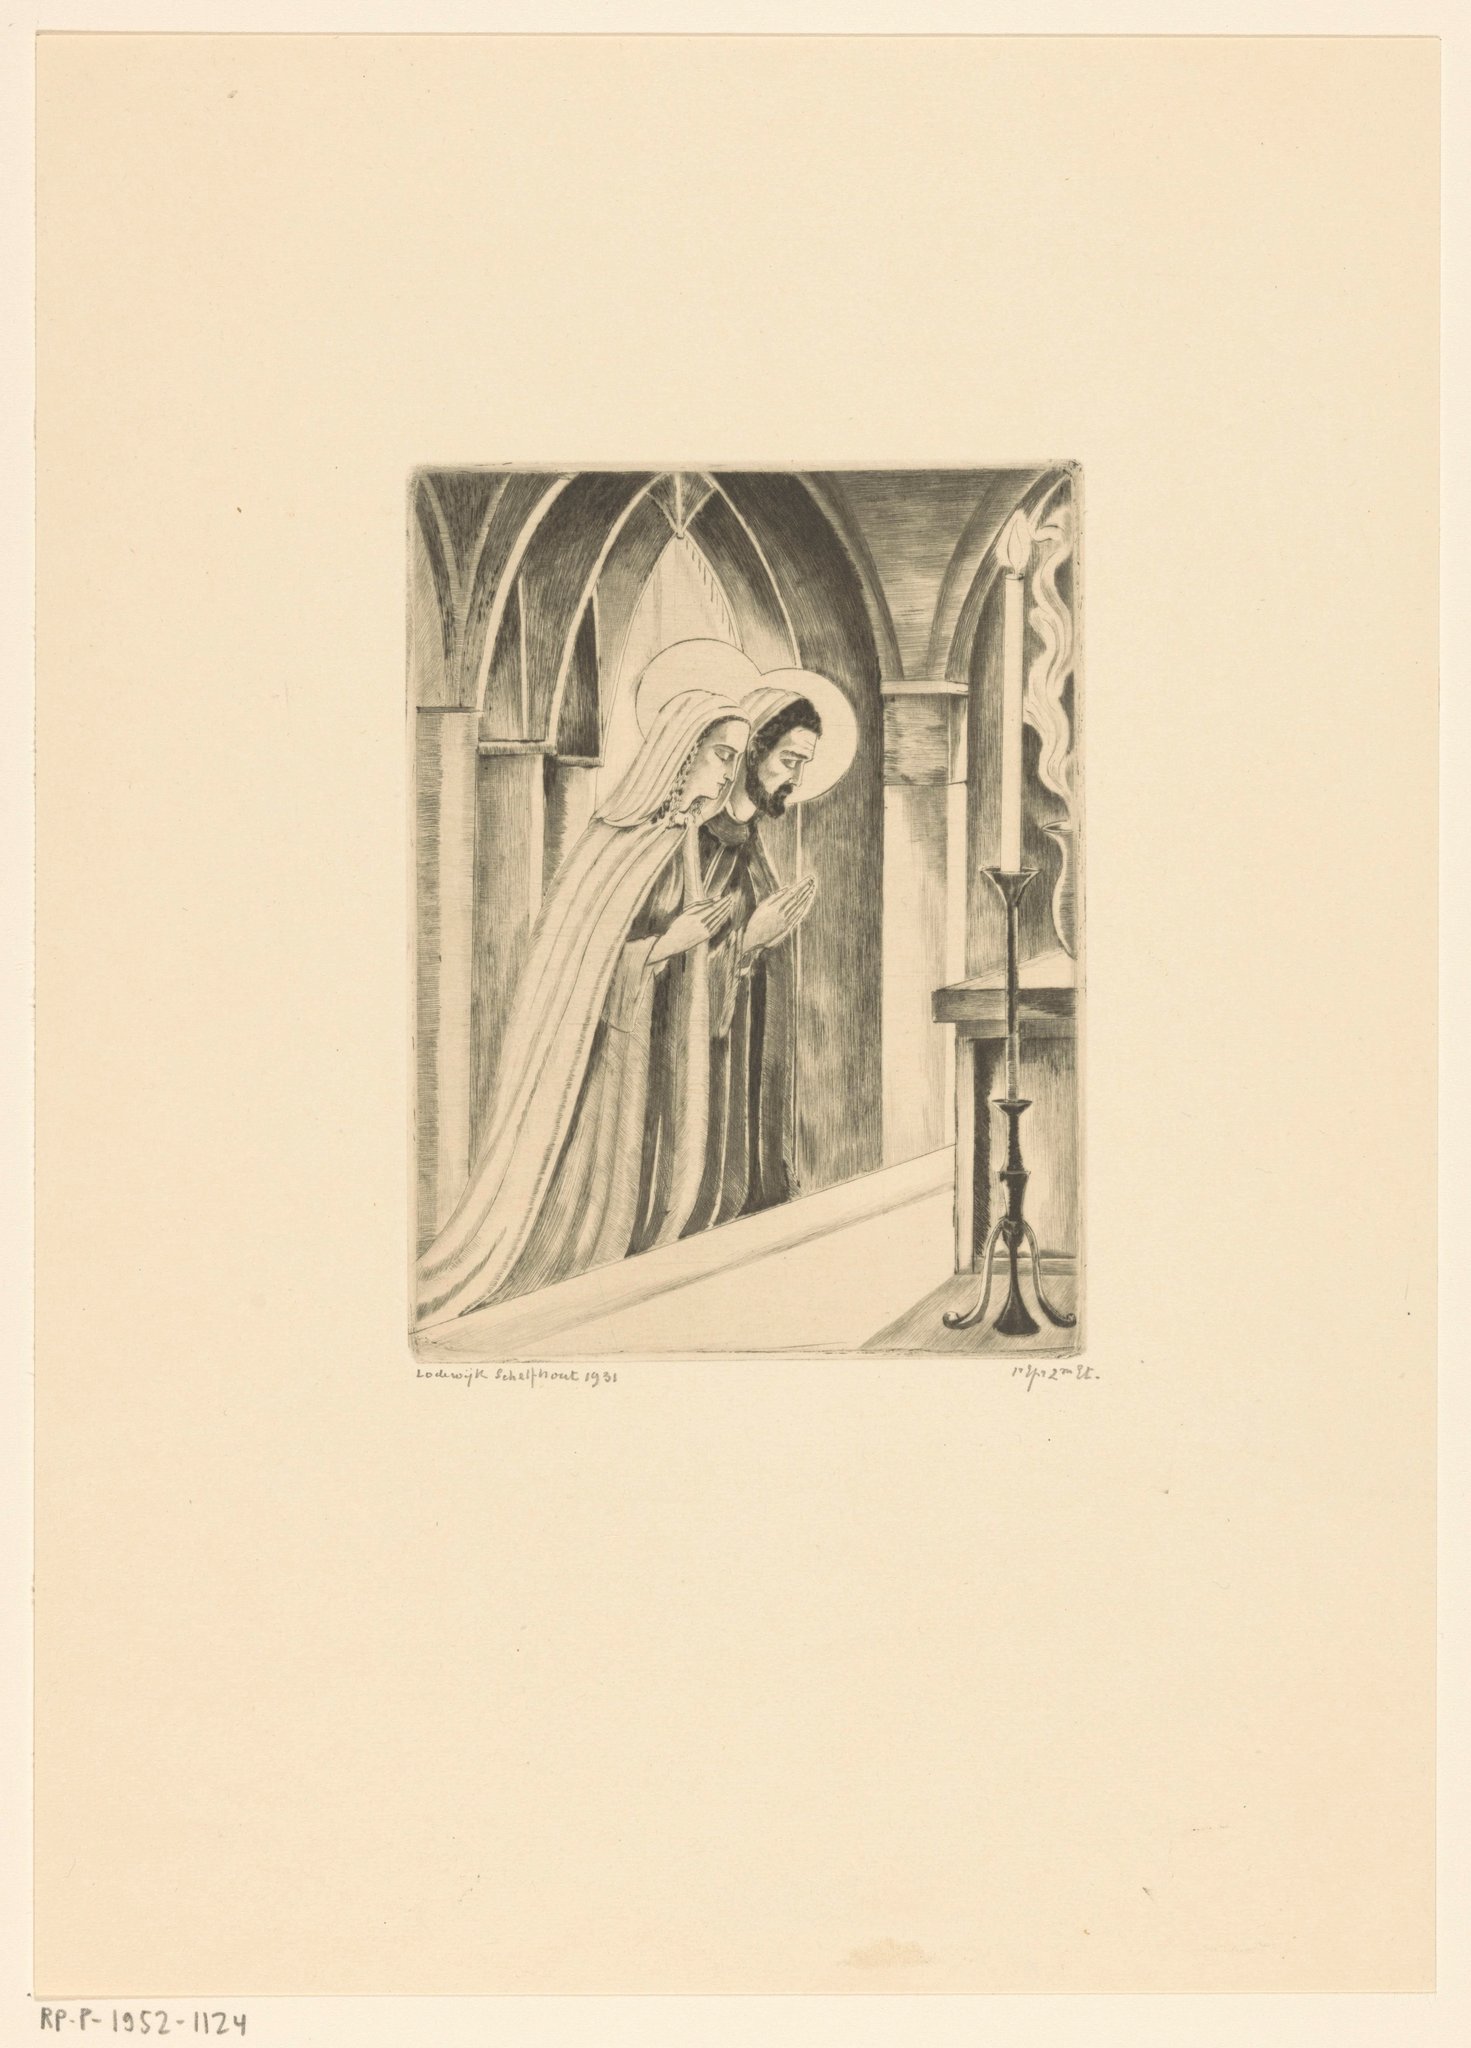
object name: print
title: Le Mariage de la Sainte Vierge et St. Joseph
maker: lodewijk schelfhout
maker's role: draughtsman, print maker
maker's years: 1881-1943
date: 1931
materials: paper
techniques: drypoint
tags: marriage of mary and joseph, 'sposalizio': they are married by the high priest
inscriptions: collector's mark: Lugt 2228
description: Maria en Jozef met samengevouwen handen, knielend bij een altaar in een gebouw met een gotisch gewelf. Rechts op de voorgrond een brandende kaars.